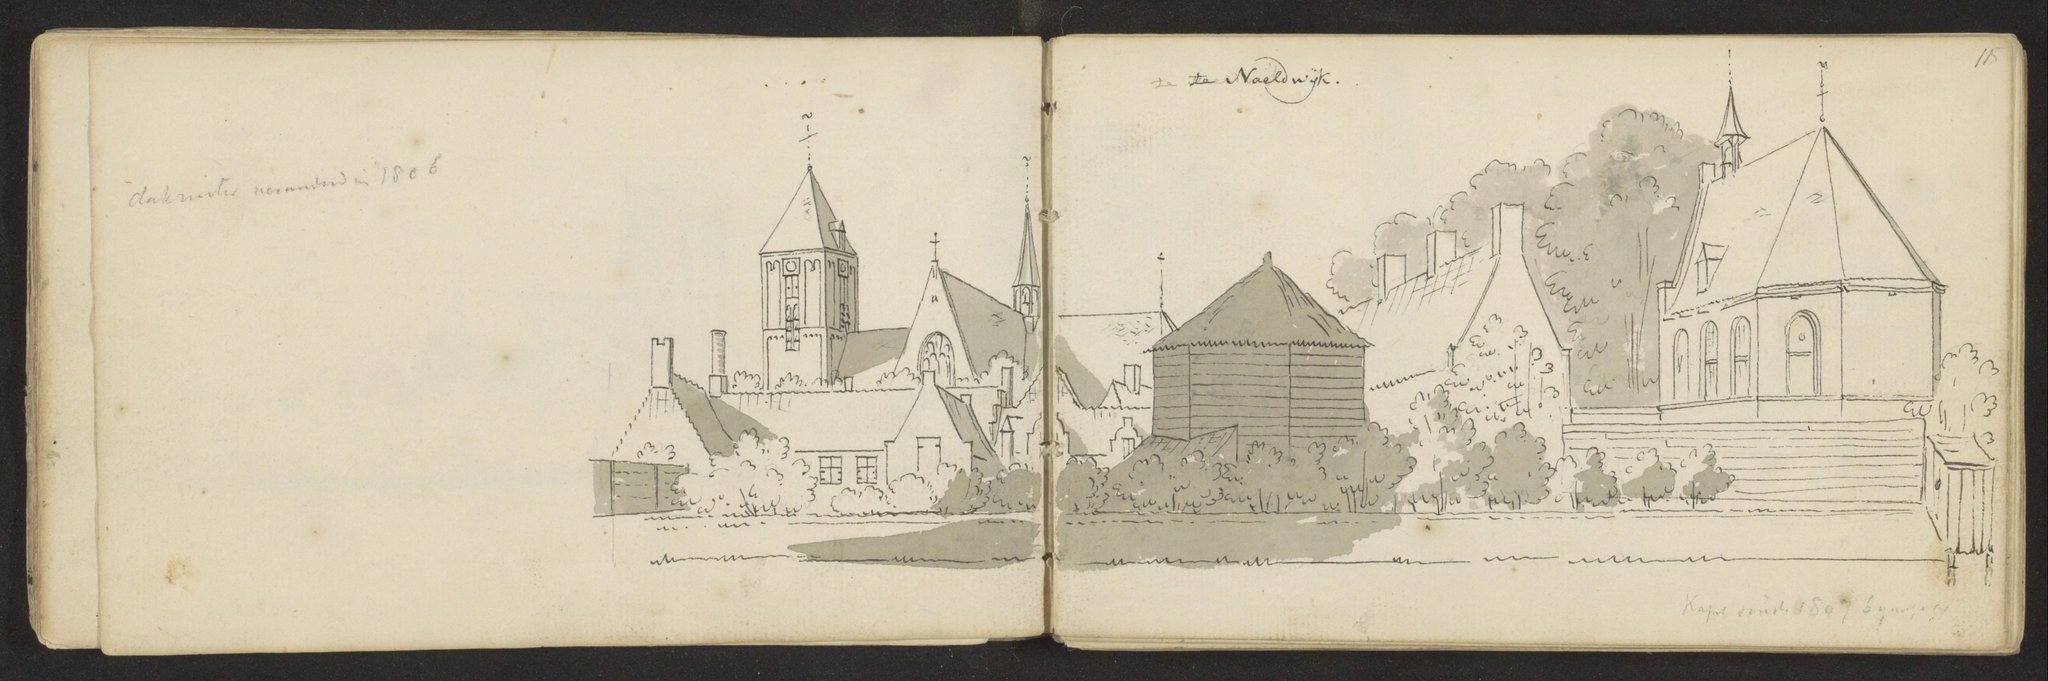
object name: sketchbook leaf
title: Dorpsgezicht met kerk te Naaldwijk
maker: abraham de haen (ii)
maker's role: draughtsman, print maker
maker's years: 1707-1748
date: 1731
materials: ink, paper, pencil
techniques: brush, pen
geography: naaldwijk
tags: village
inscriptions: annotation: ‘te Naaldwijk.’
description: Blad 10 verso en 11 recto uit een schetsboek met 78 bladen.